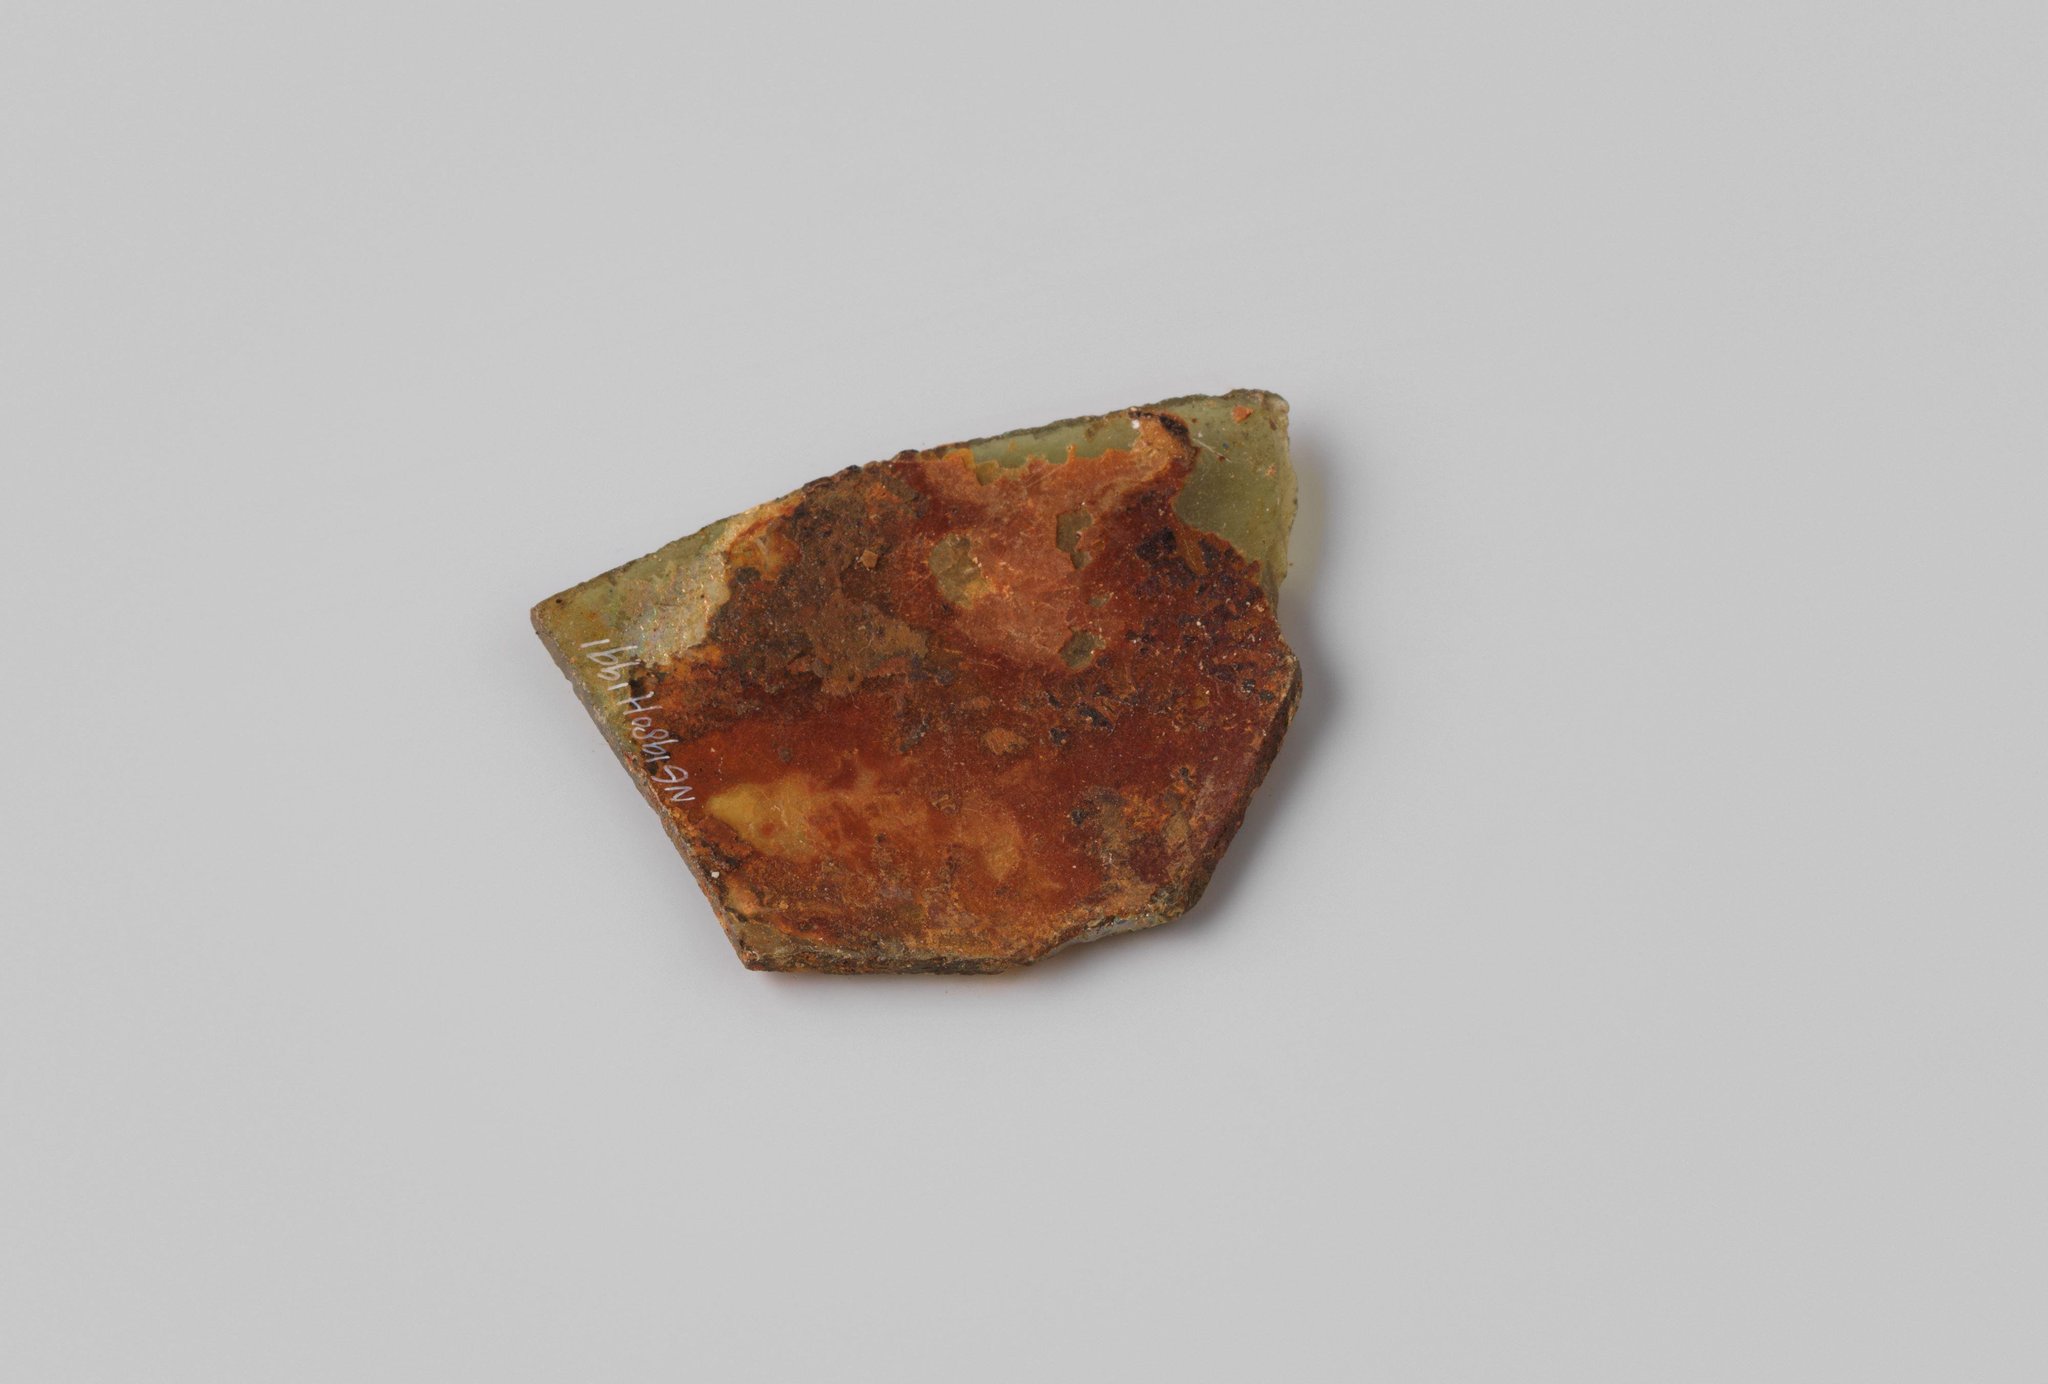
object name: wine bottle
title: Scherf van een wijnfles uit het wrak van de Oost-Indiëvaarder Hollandia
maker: Anonymous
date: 1700-1743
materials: glass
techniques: green glass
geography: netherlands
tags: verenigde oostindische compagnie, hollandia (schip), annet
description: Typologically not identifiable, belly, fragment.